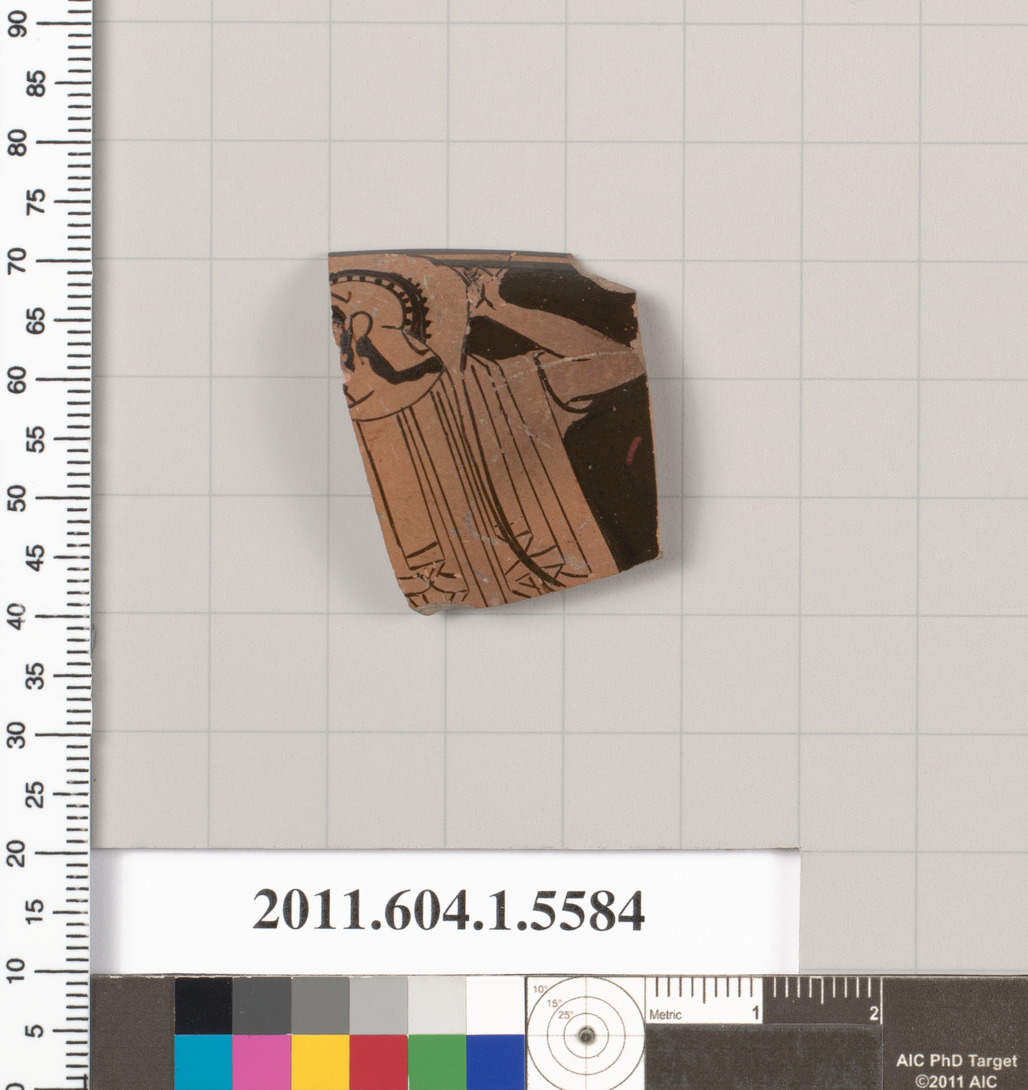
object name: kylix fragment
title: Terracotta rim fragment of a kylix (drinking cup)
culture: greek, attic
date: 510-490 BCE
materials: terracotta